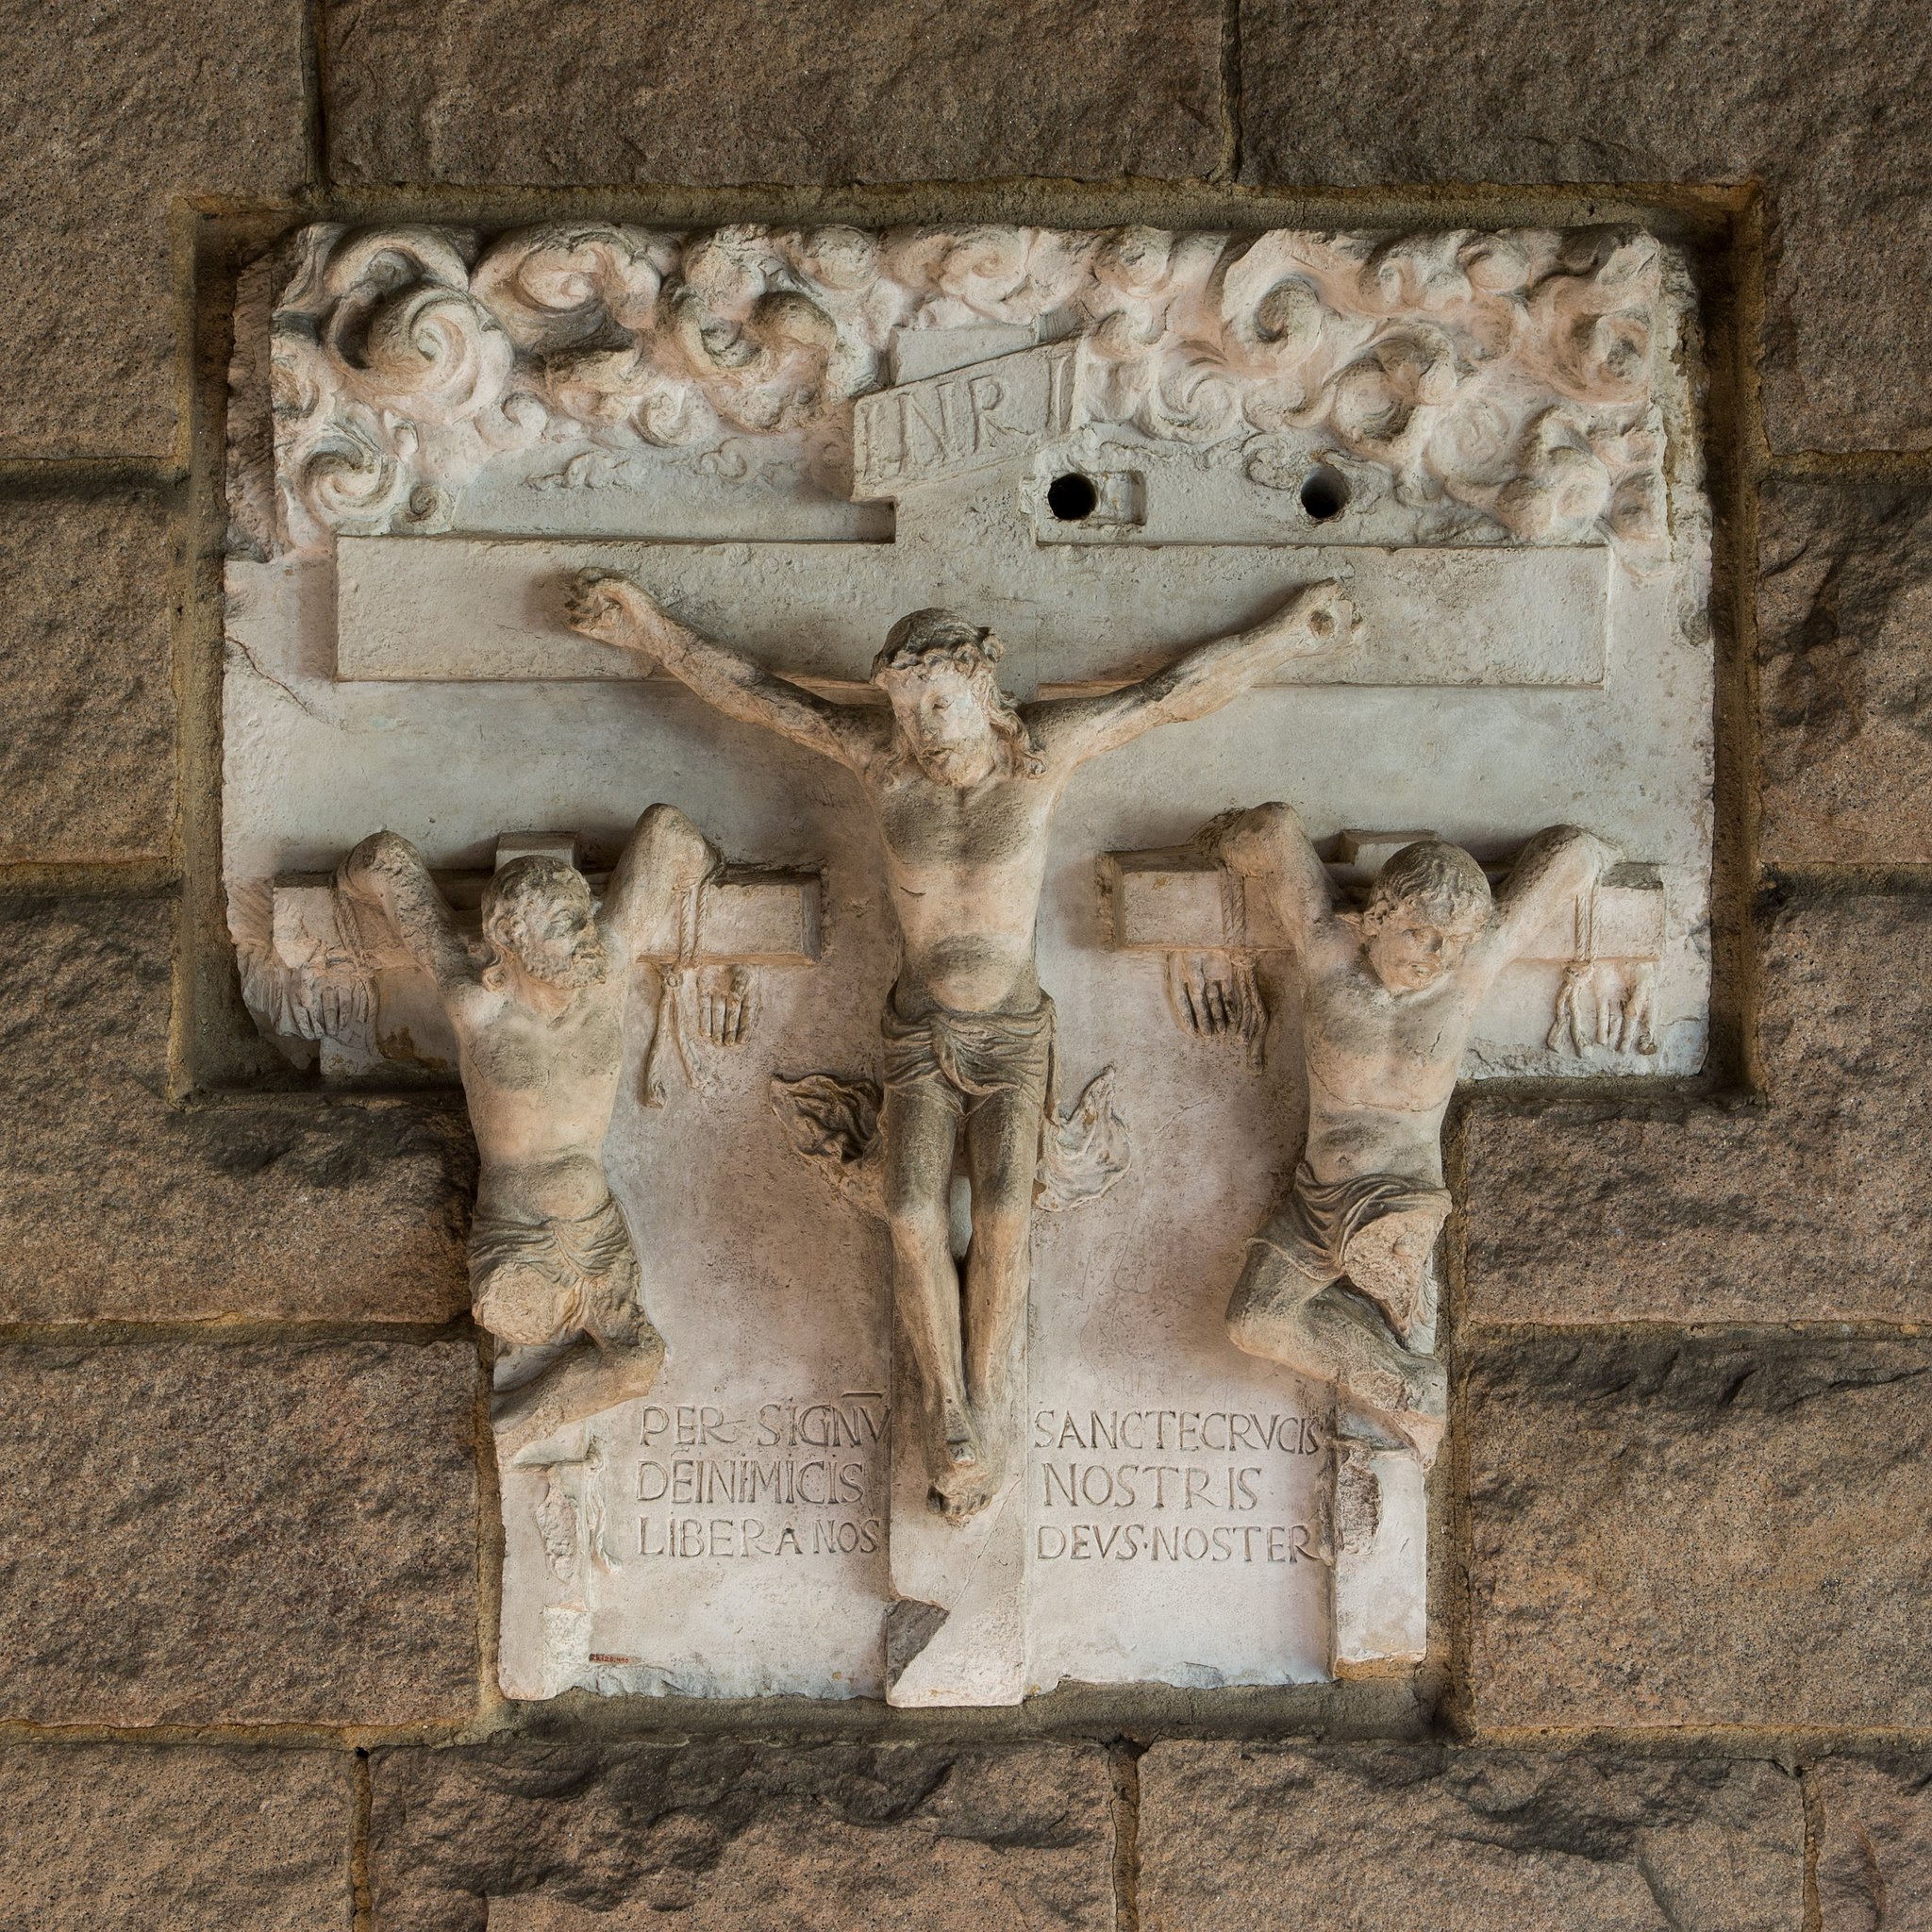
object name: relief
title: The Crucifixion (from Scenes from the Passion of Christ)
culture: french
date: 1501-1533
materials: stone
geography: france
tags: christ,crucifixion